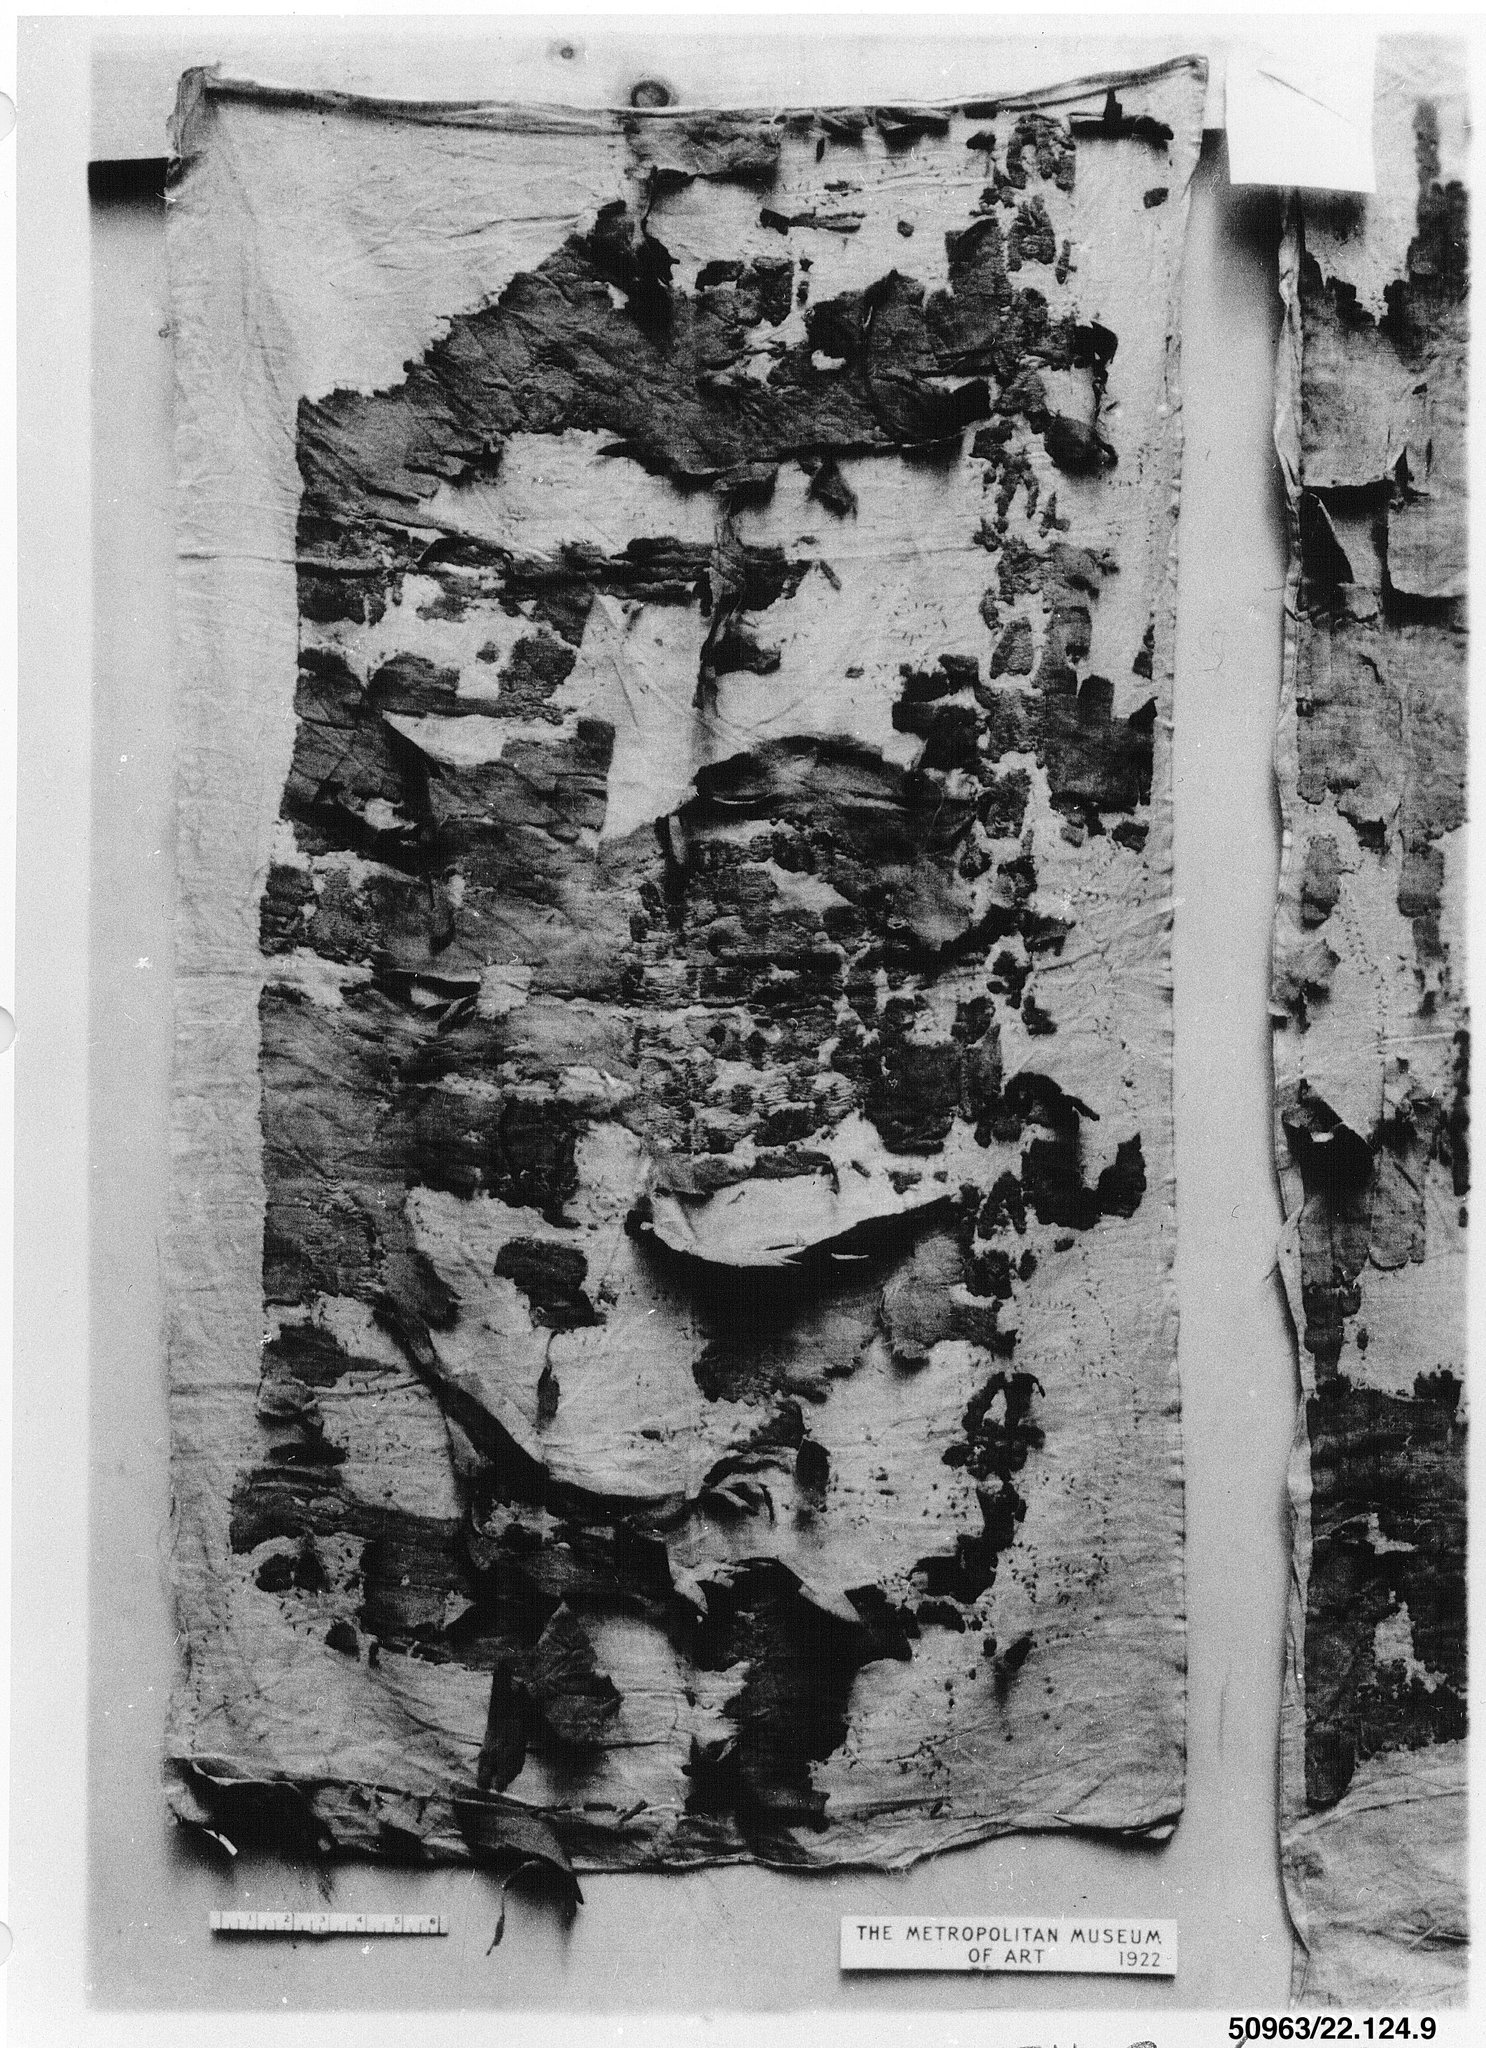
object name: fragment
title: Textile Fragment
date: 301-600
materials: linen, wool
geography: egypt